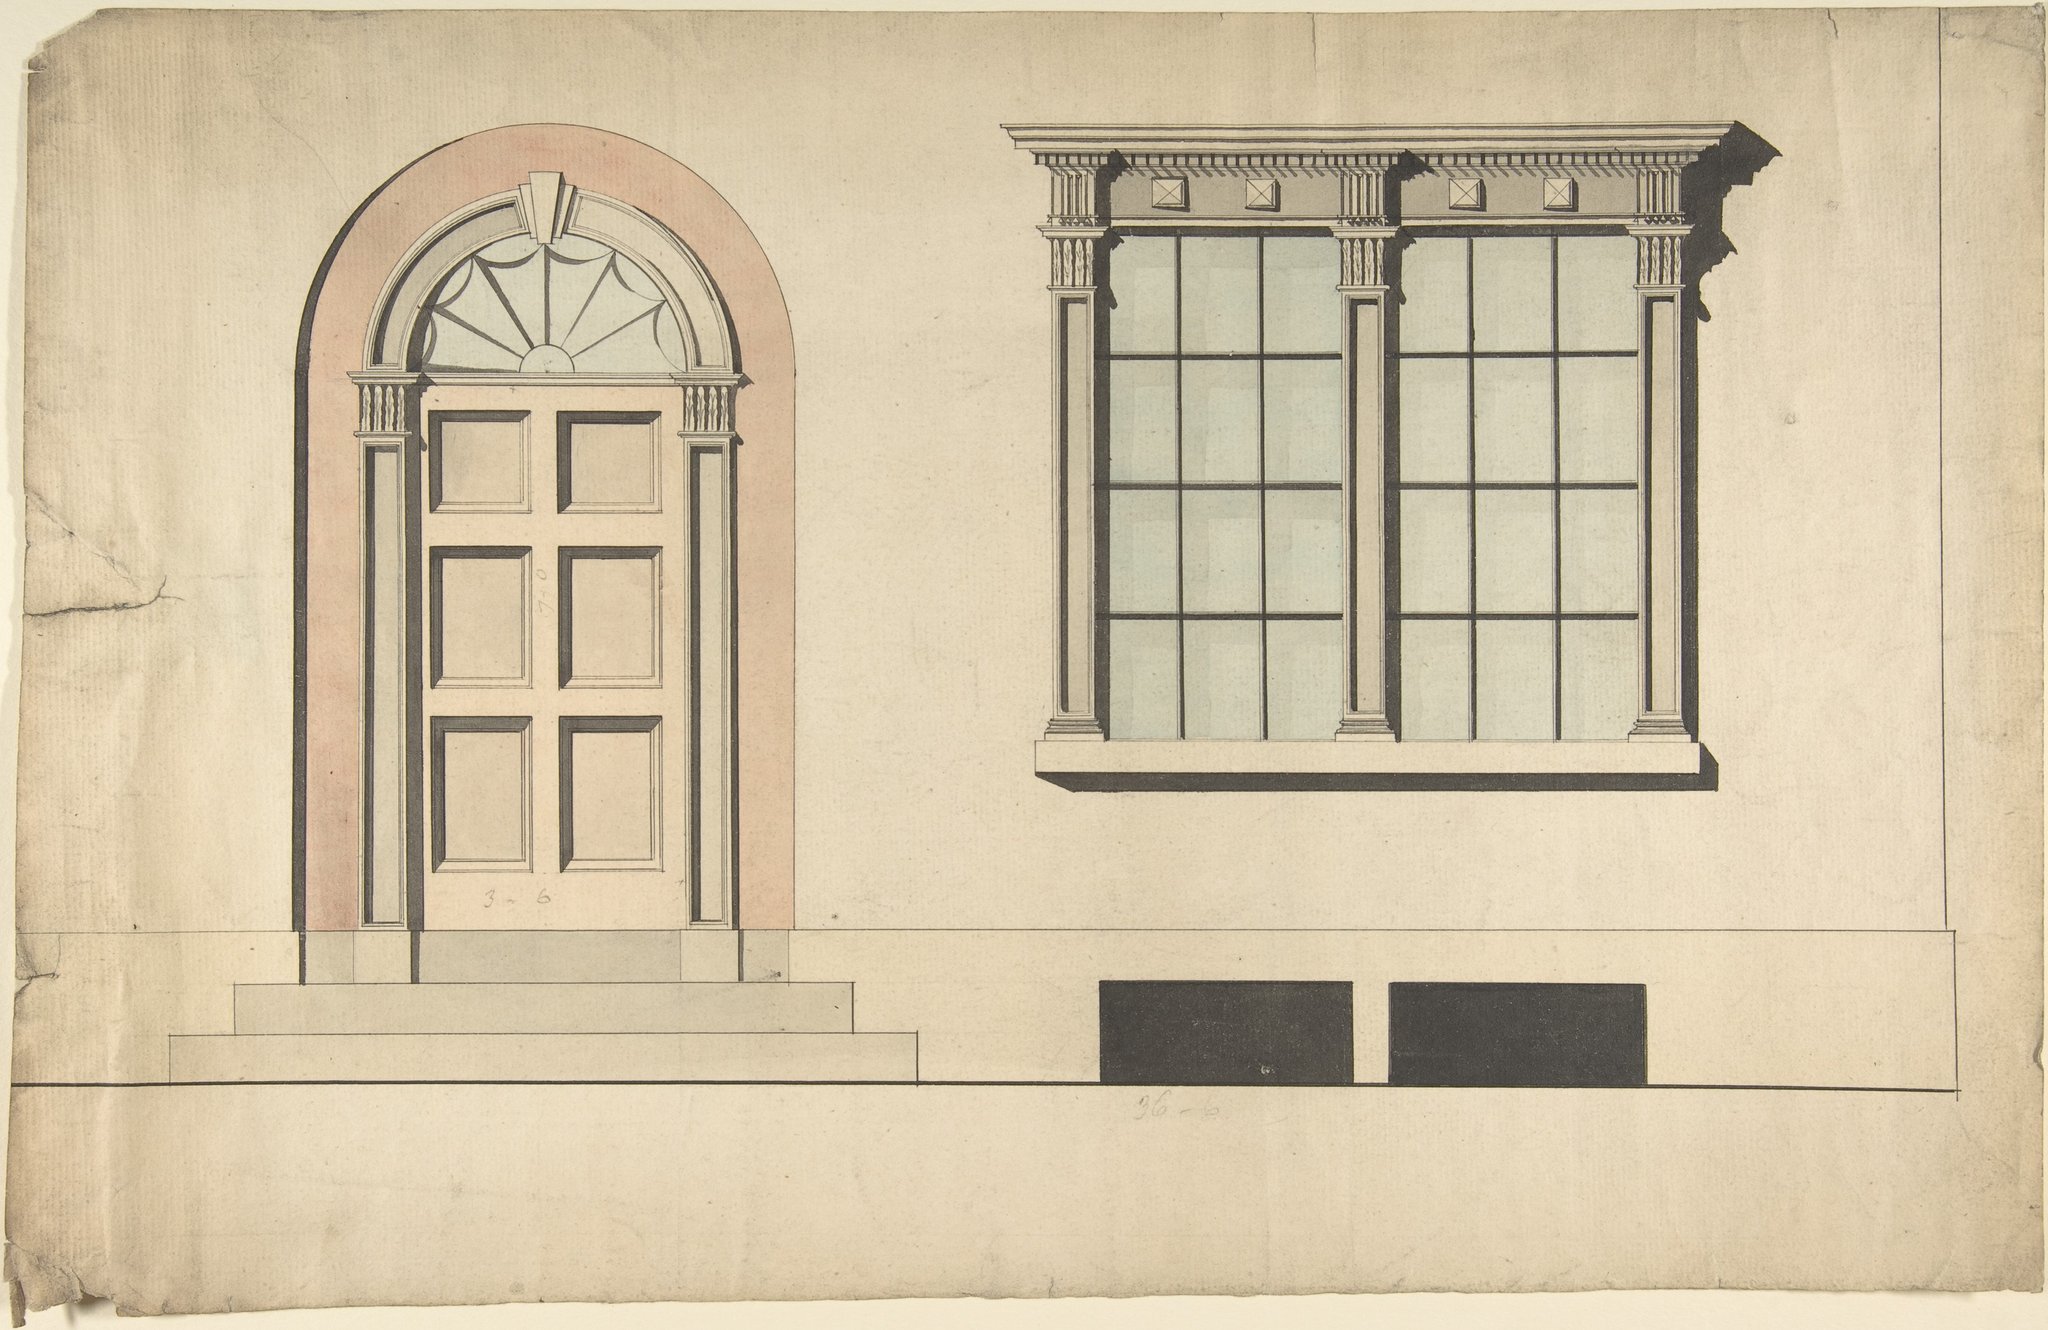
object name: drawing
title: Design for an Exterior Doorway and Window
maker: anonymous, british, early 19th century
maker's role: artist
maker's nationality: british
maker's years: 1800-1850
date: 1801-1850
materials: ink, watercolor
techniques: brush, pen, wash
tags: architecture,doors,windows